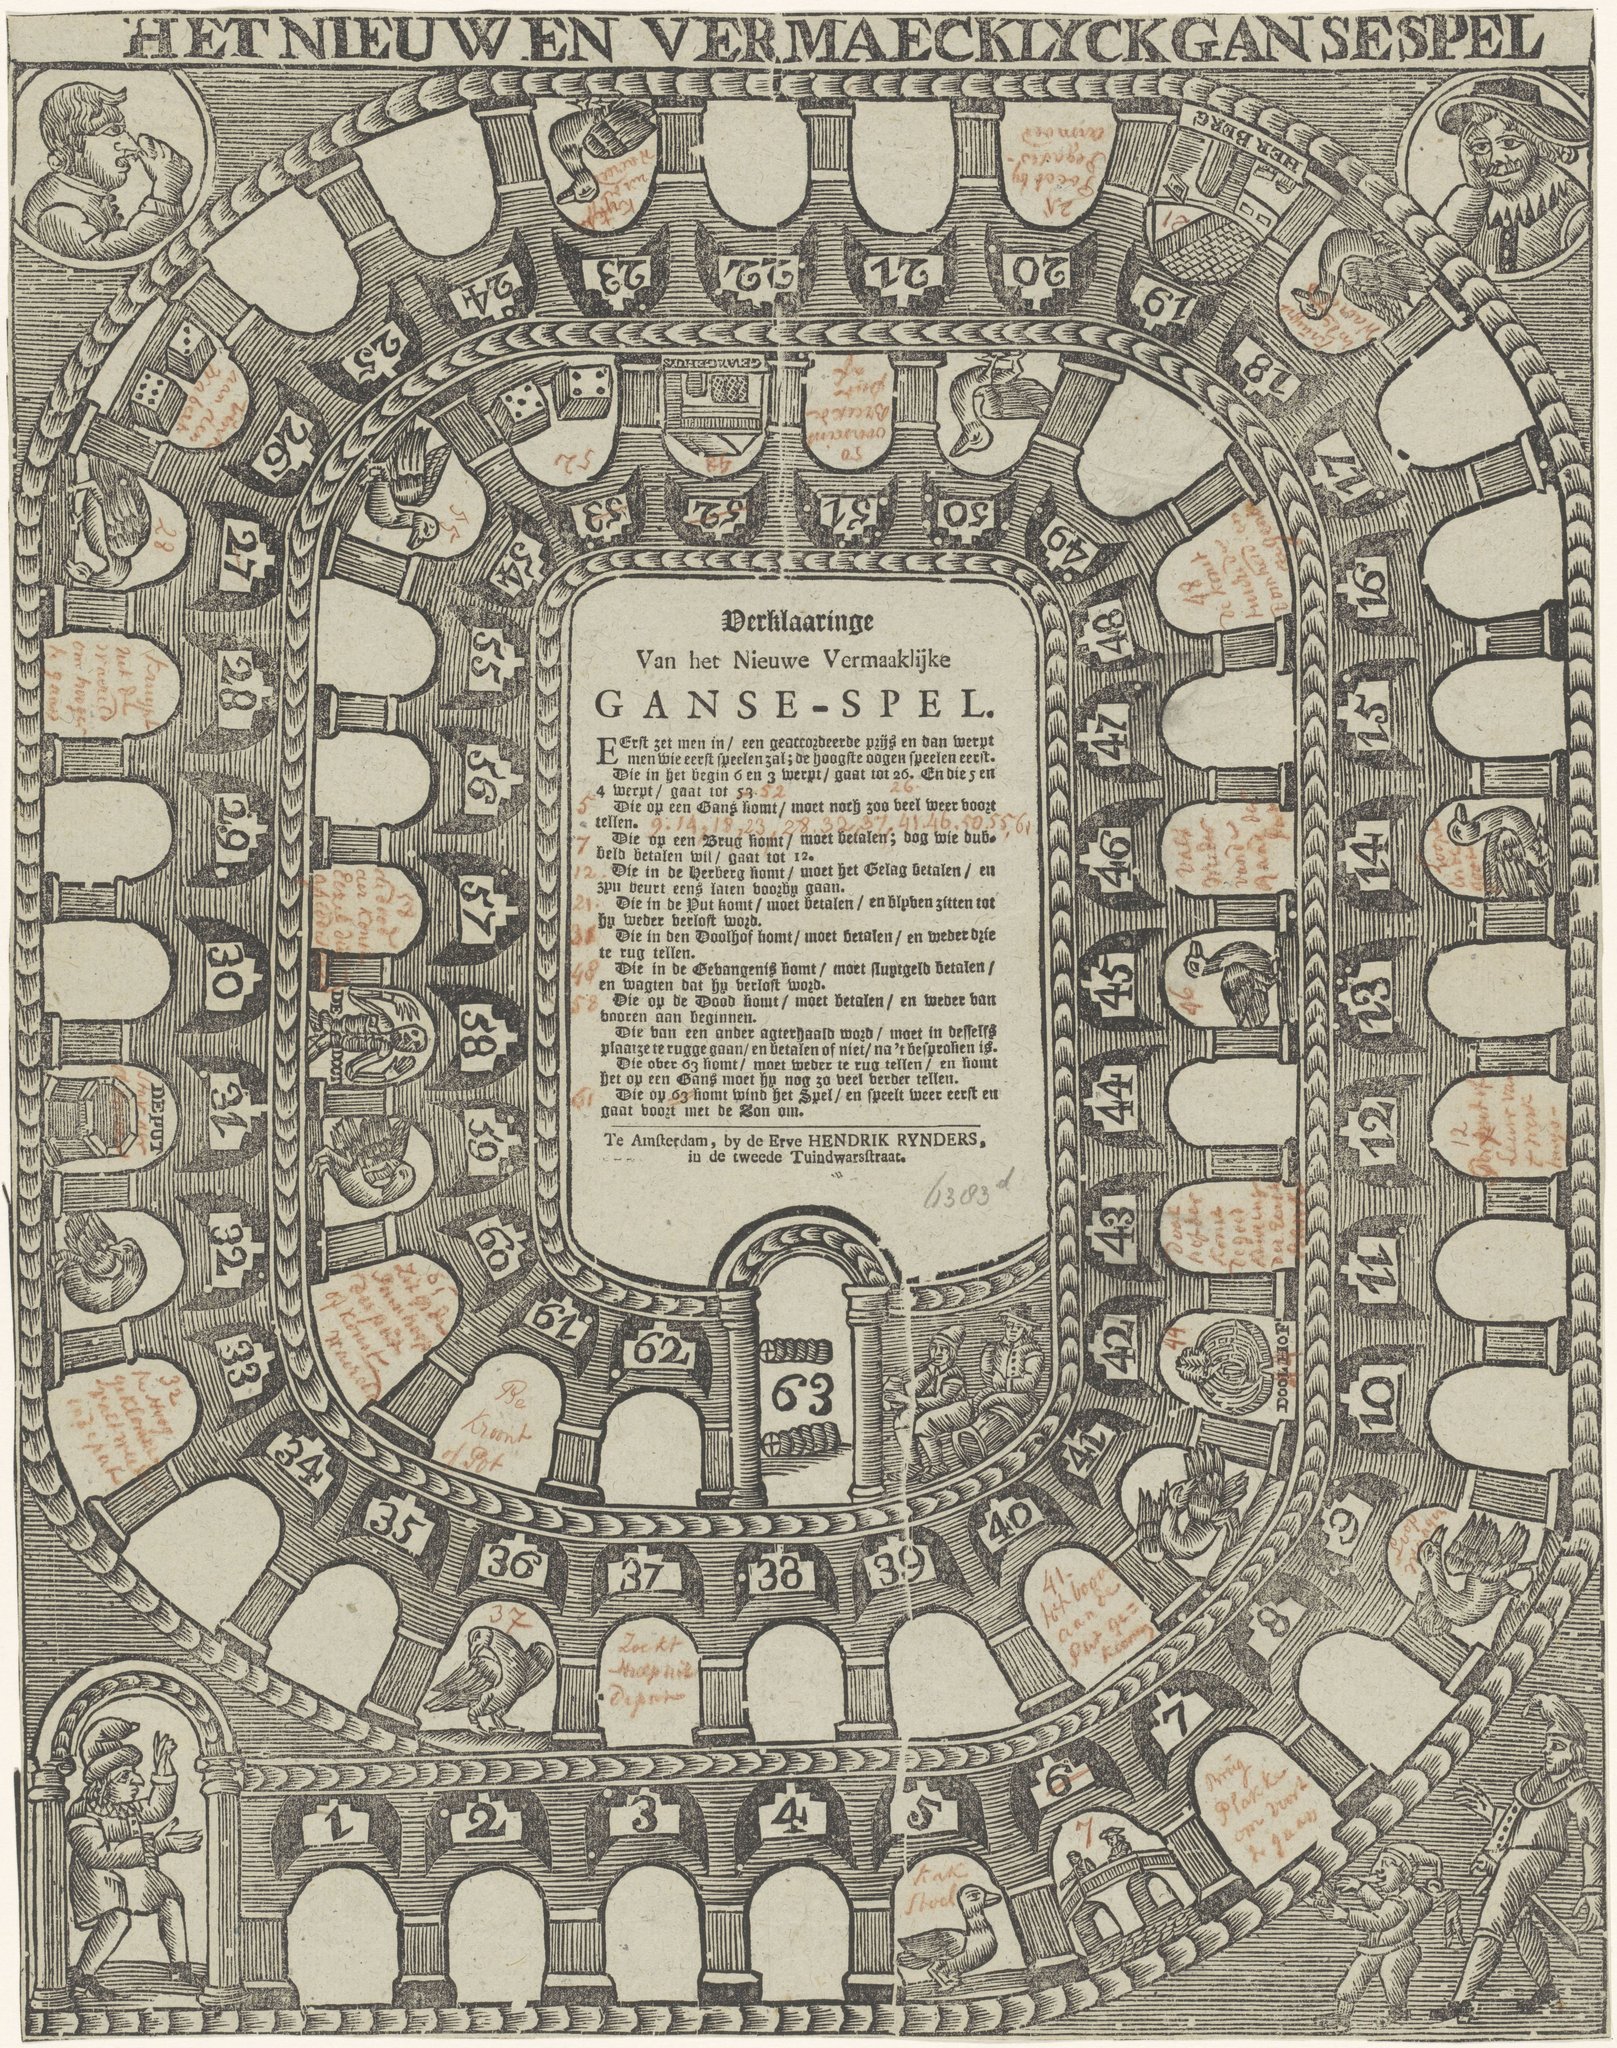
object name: print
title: Ganzenbordspel, ca. 1830-1850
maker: Anonymous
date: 1831-1854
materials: chalk, paper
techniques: letterpress printing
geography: netherlands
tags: goose-game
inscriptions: collector's mark: Lugt 2228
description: Ganzenbordspel met vakjes 1-63. In het midden de spelregels. Met opschriften in rood krijt. Onderdeel van een groep van kinder- en gezelschapsspelen gedrukt in de periode ca. 1750-1850.